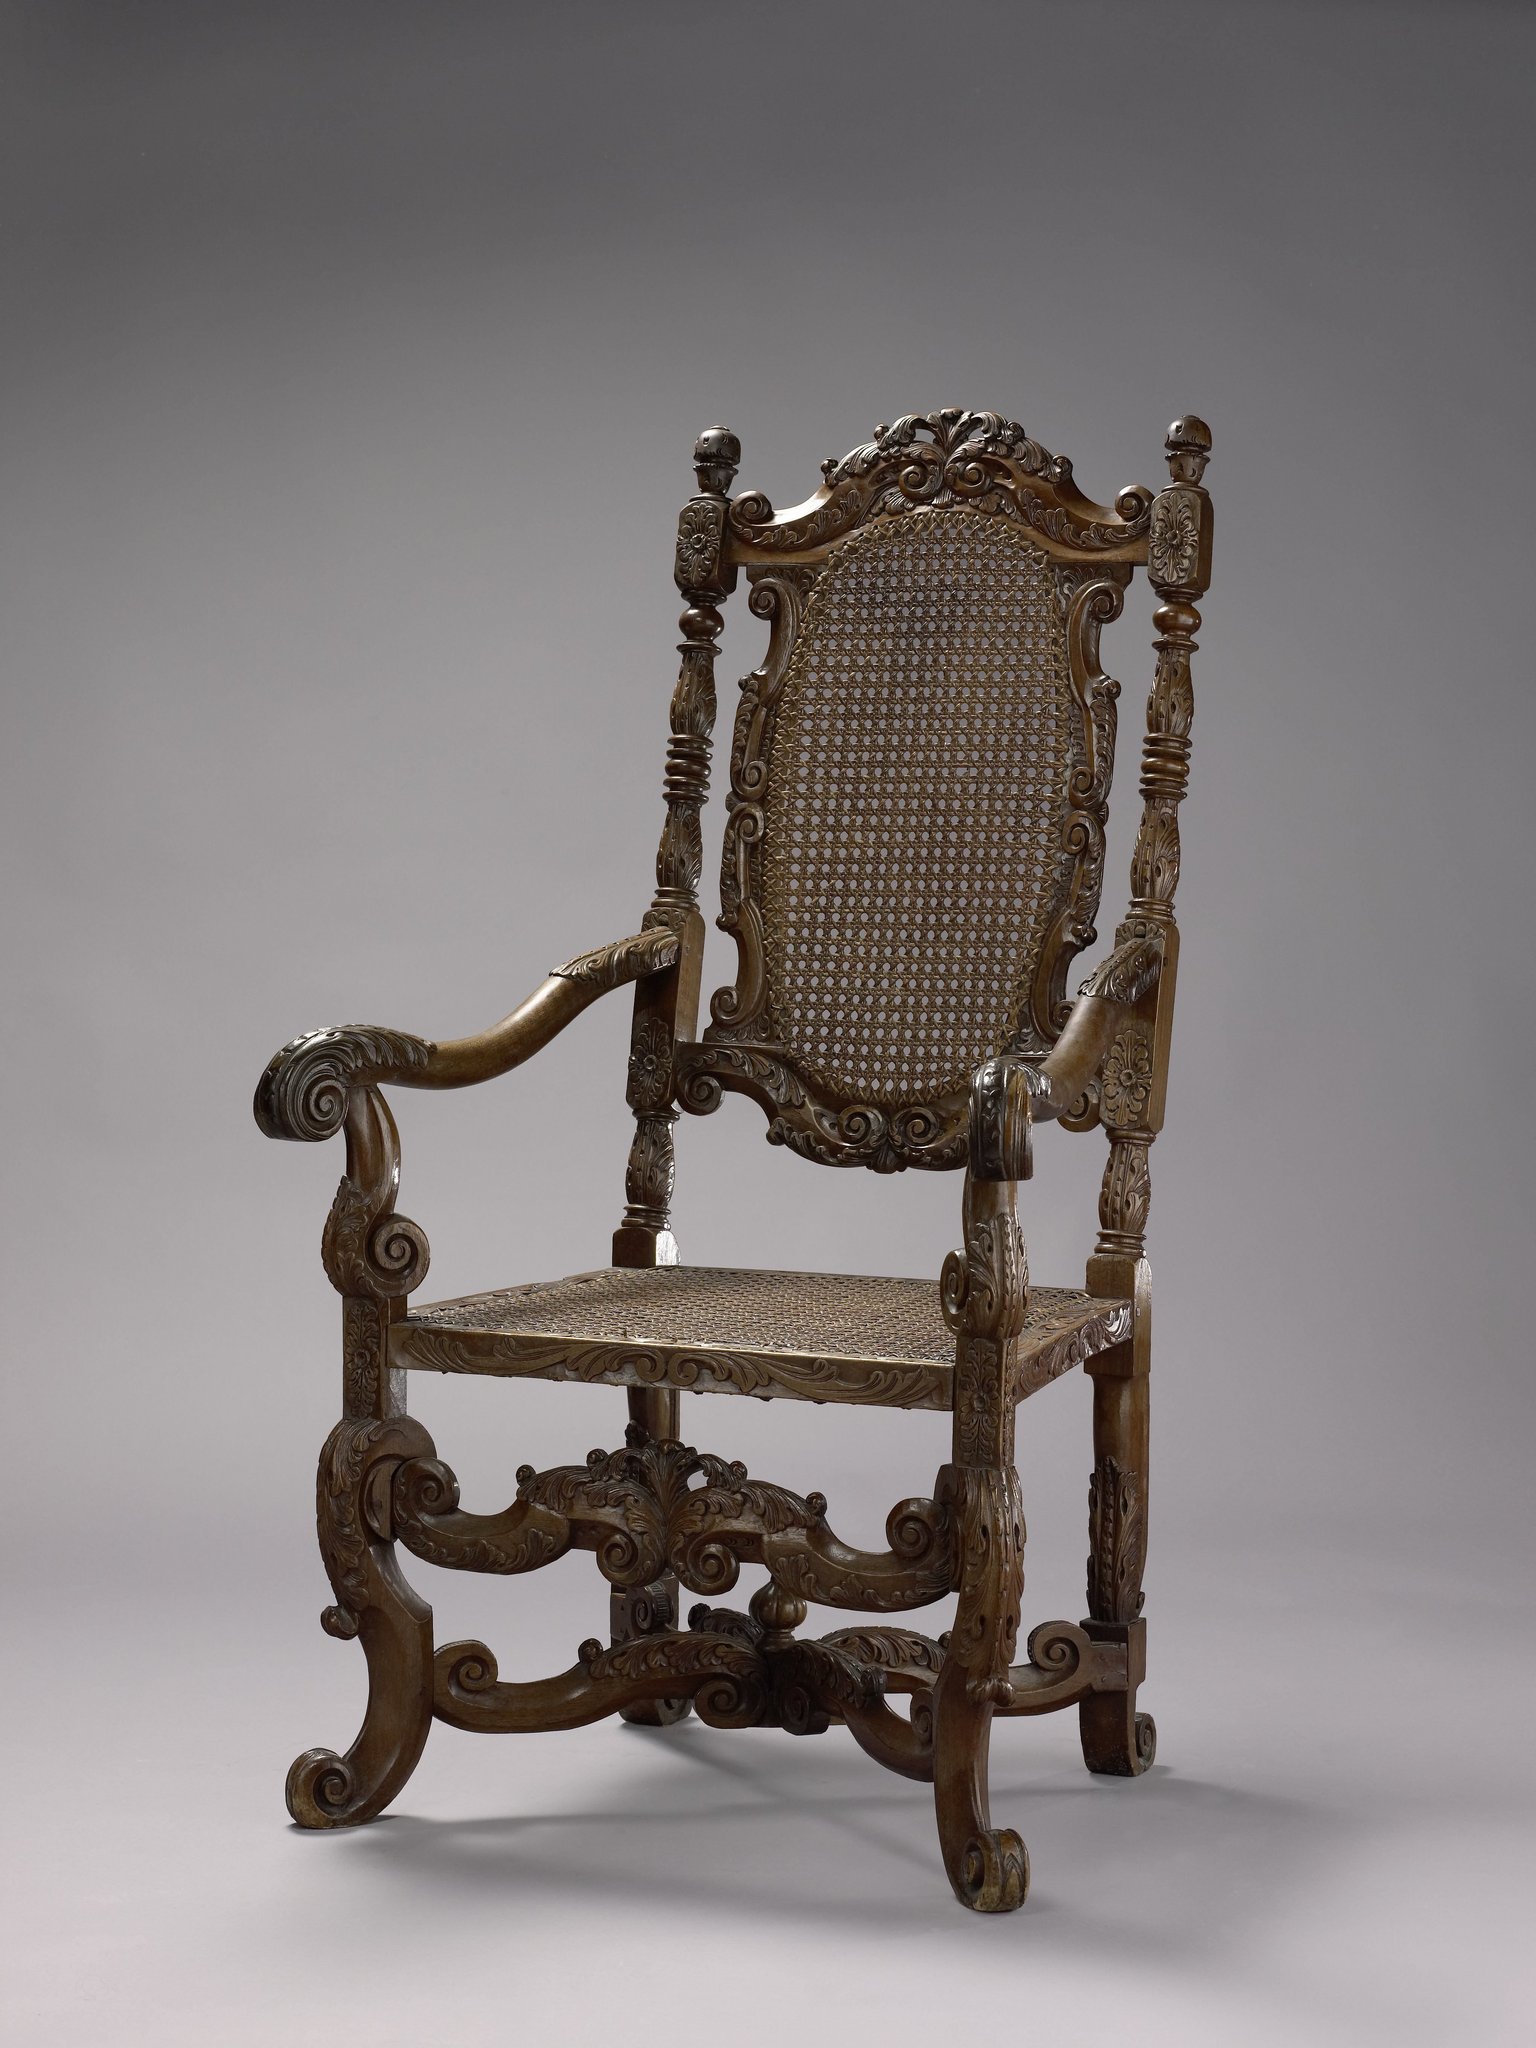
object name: furniture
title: Armstoel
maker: Anonymous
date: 1695-1705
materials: wood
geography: netherlands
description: Armstoel van notenhout. Het meubel is met riet bespannen en heeft gebroken S-vormige poten versierd met een voluut en acanthusblad. Het kruis is X-vormig. De vrijstaande hoekstijlen van de hoge rug vertonen huis en geledingen met acanthusblad en eindigen in vaasjes. De armstutten in de vorm van S-voluten dragen de armleggers, die gehold zijn en eindigen in naar buiten gerichte voluten, versierd met acanthusblad, evenals het achterpand. De huizen hebben rozetten en de zitregels zijn met acanthusblad versierd.